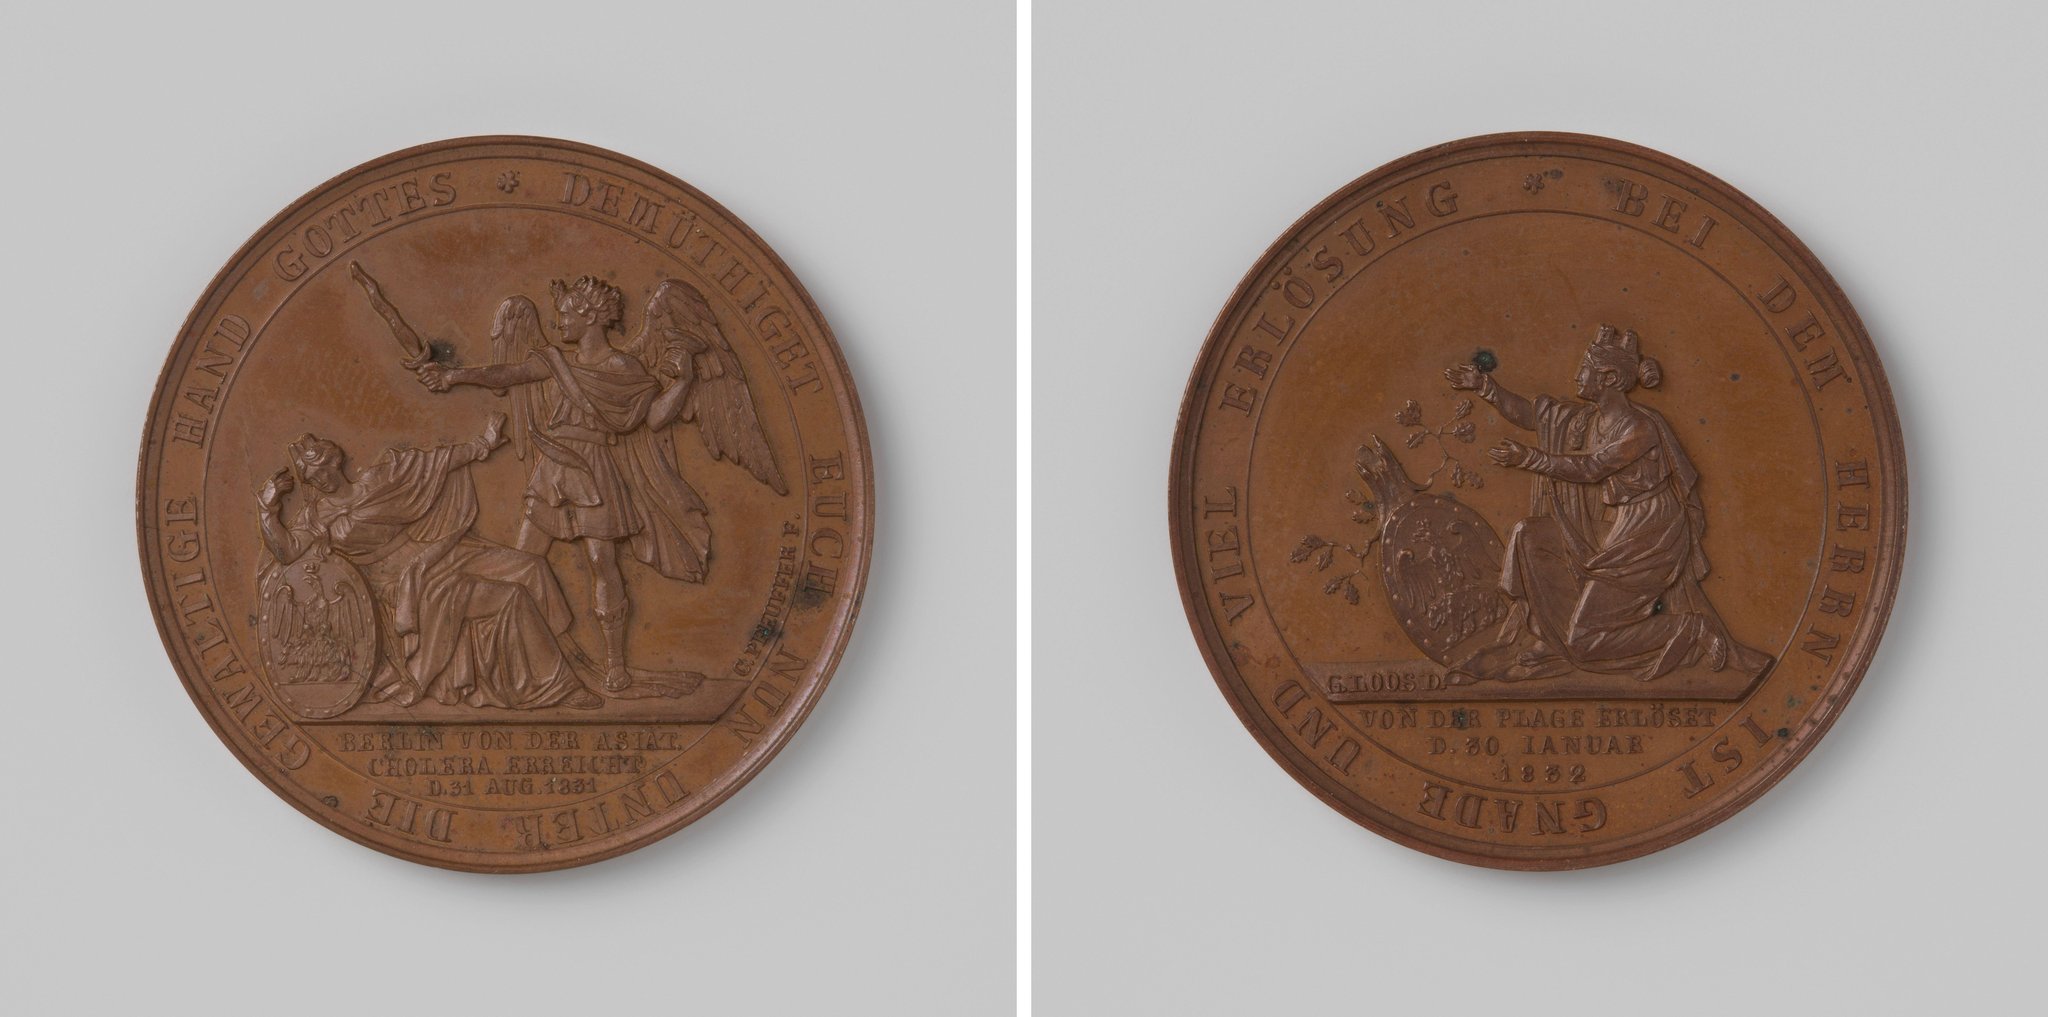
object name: history medal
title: Cholera-epidemie te Berlijn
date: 1832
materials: bronze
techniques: striking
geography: berlin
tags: berlin